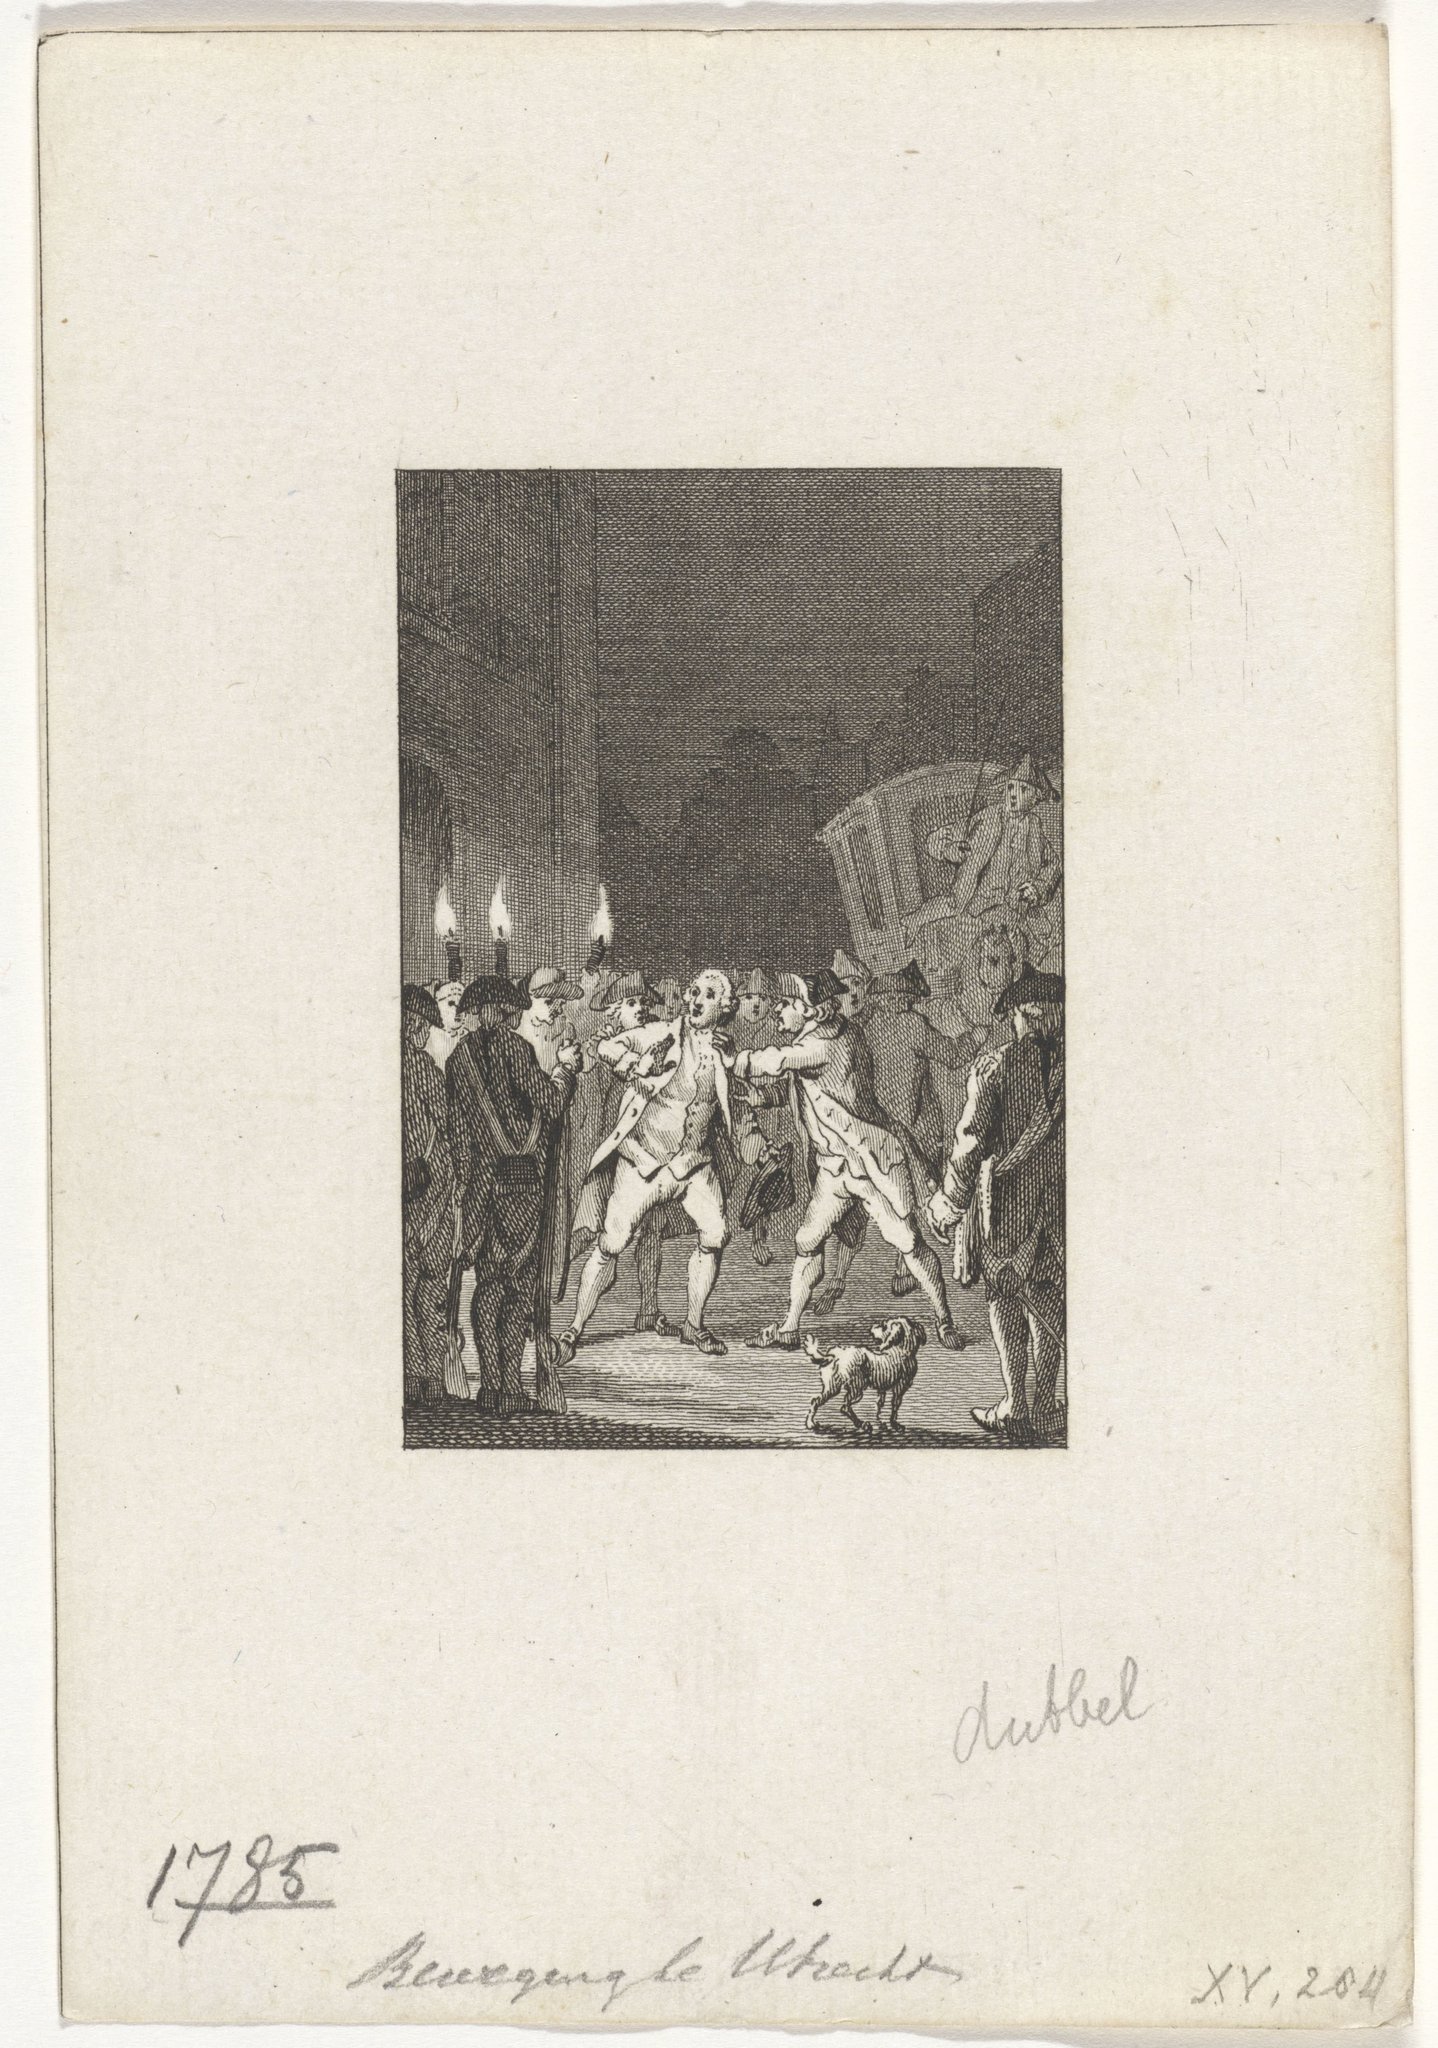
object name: history print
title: Burgemeester Loten aangevallen te Utrecht, 1785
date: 1783-1795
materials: paper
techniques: etching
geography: amsterdam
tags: mayor, arnoud loten, street-fights, riots, utrecht, patriots (1780-1795)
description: Illustratie voor: J. Fokke. Geschiedenissen der Vereenigde Nederlanden voor de vaderlandsche jeugd. Amsterdam: Johannes Allart, 1783-1795, 25 delen. deel XV.